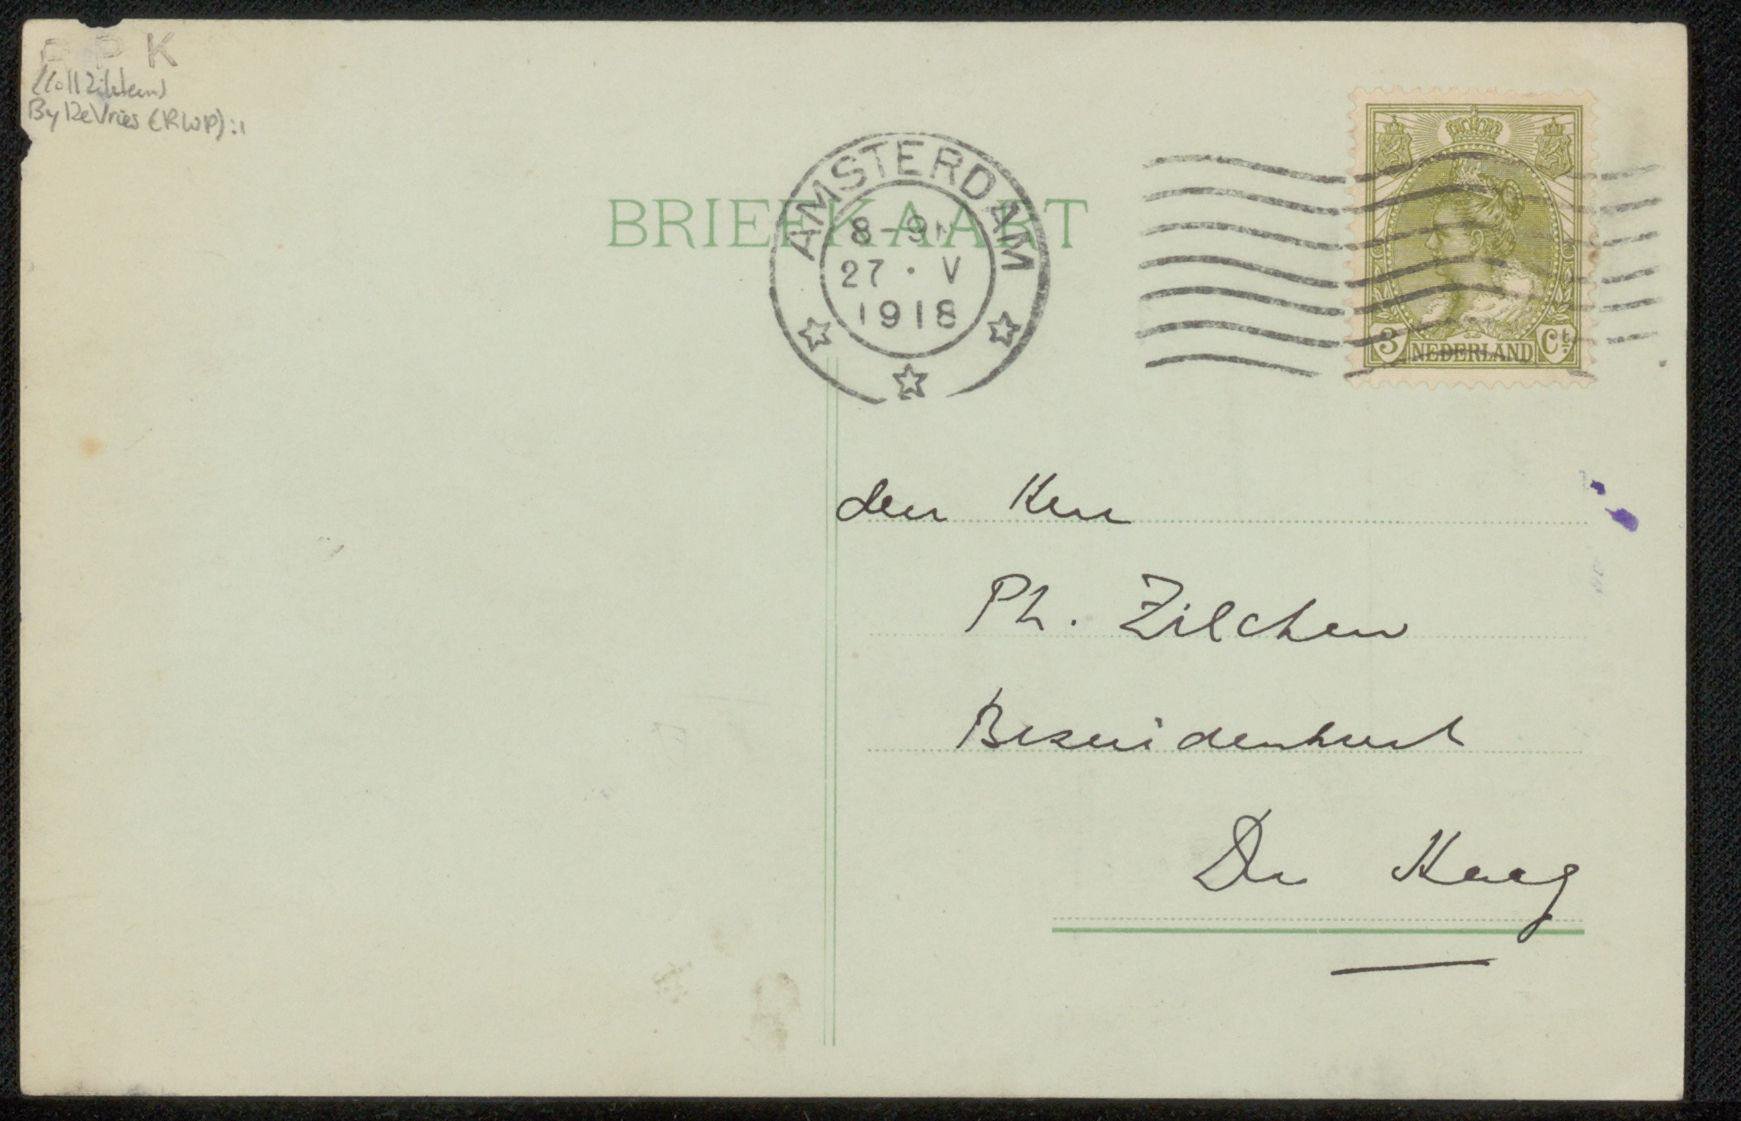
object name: postcard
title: Briefkaart aan Philip Zilcken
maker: Anonymous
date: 1918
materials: cardboard, ink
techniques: pen, writing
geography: amsterdam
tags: the hague, painter, draughtsman, philip zilcken, printed matter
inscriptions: collector's mark: ‘RPK’